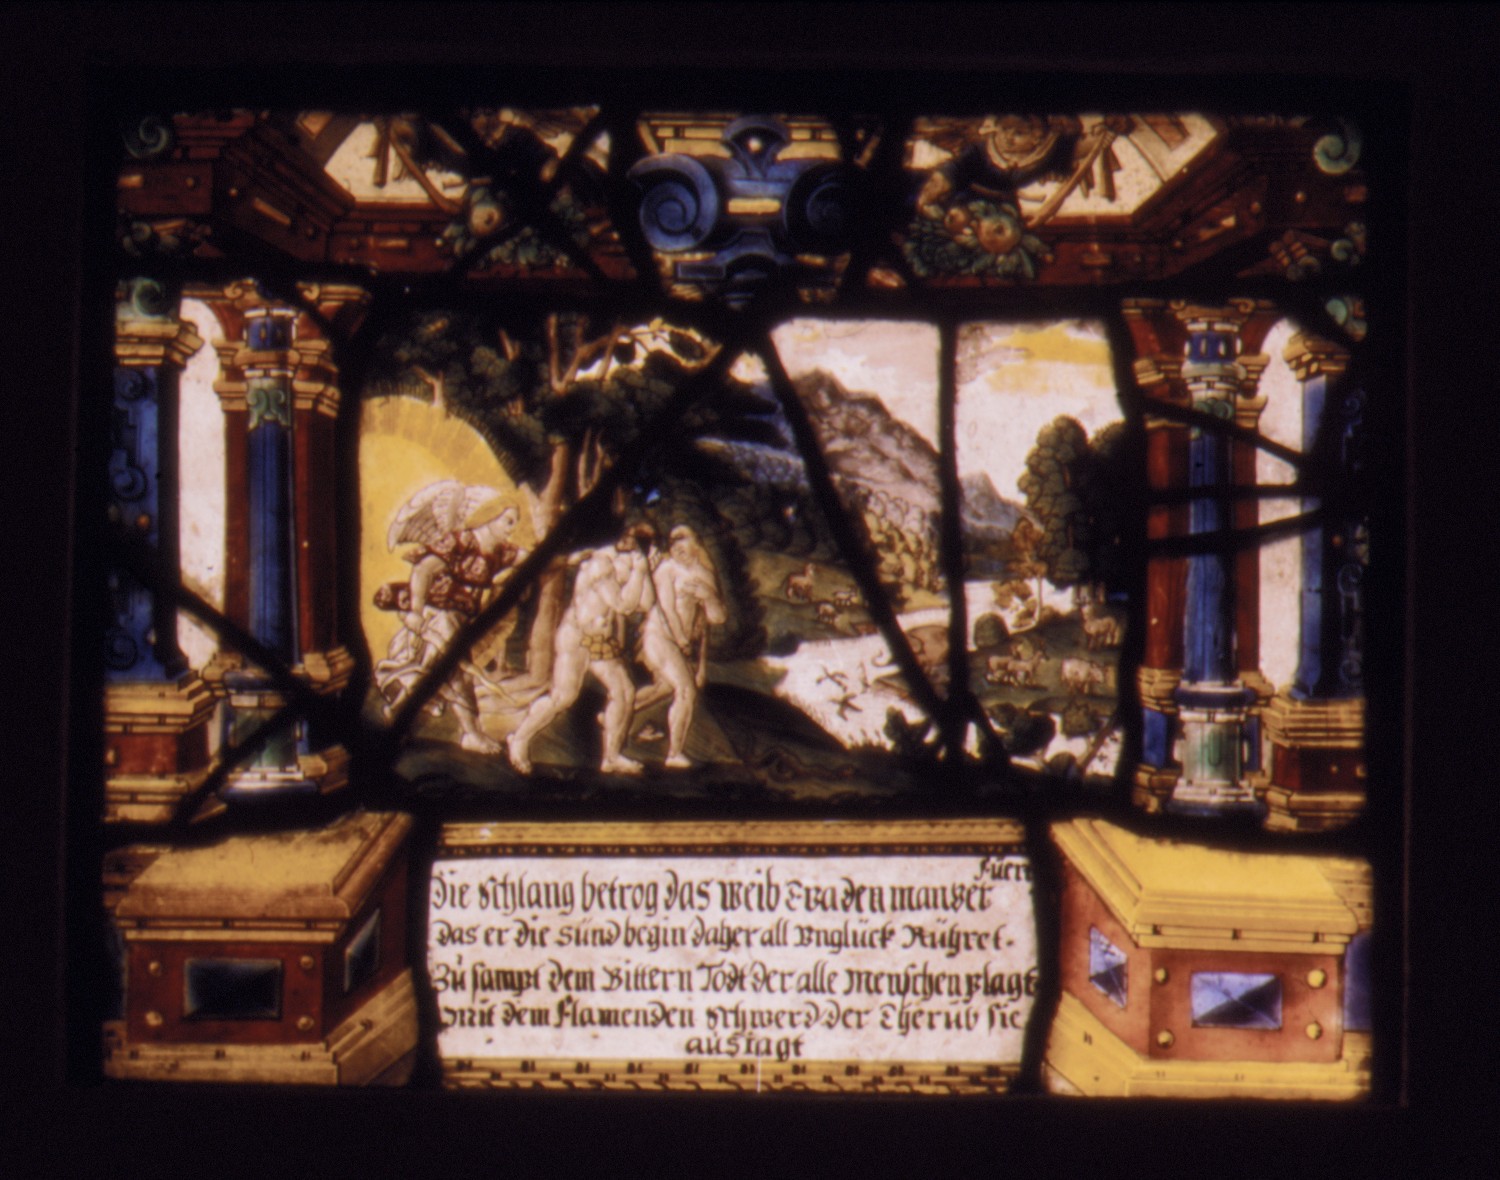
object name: panel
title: The Expulsion from Paradise (one of a set of four)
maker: muller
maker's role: maker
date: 1634-1666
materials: glass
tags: animals,angels,adam,eve